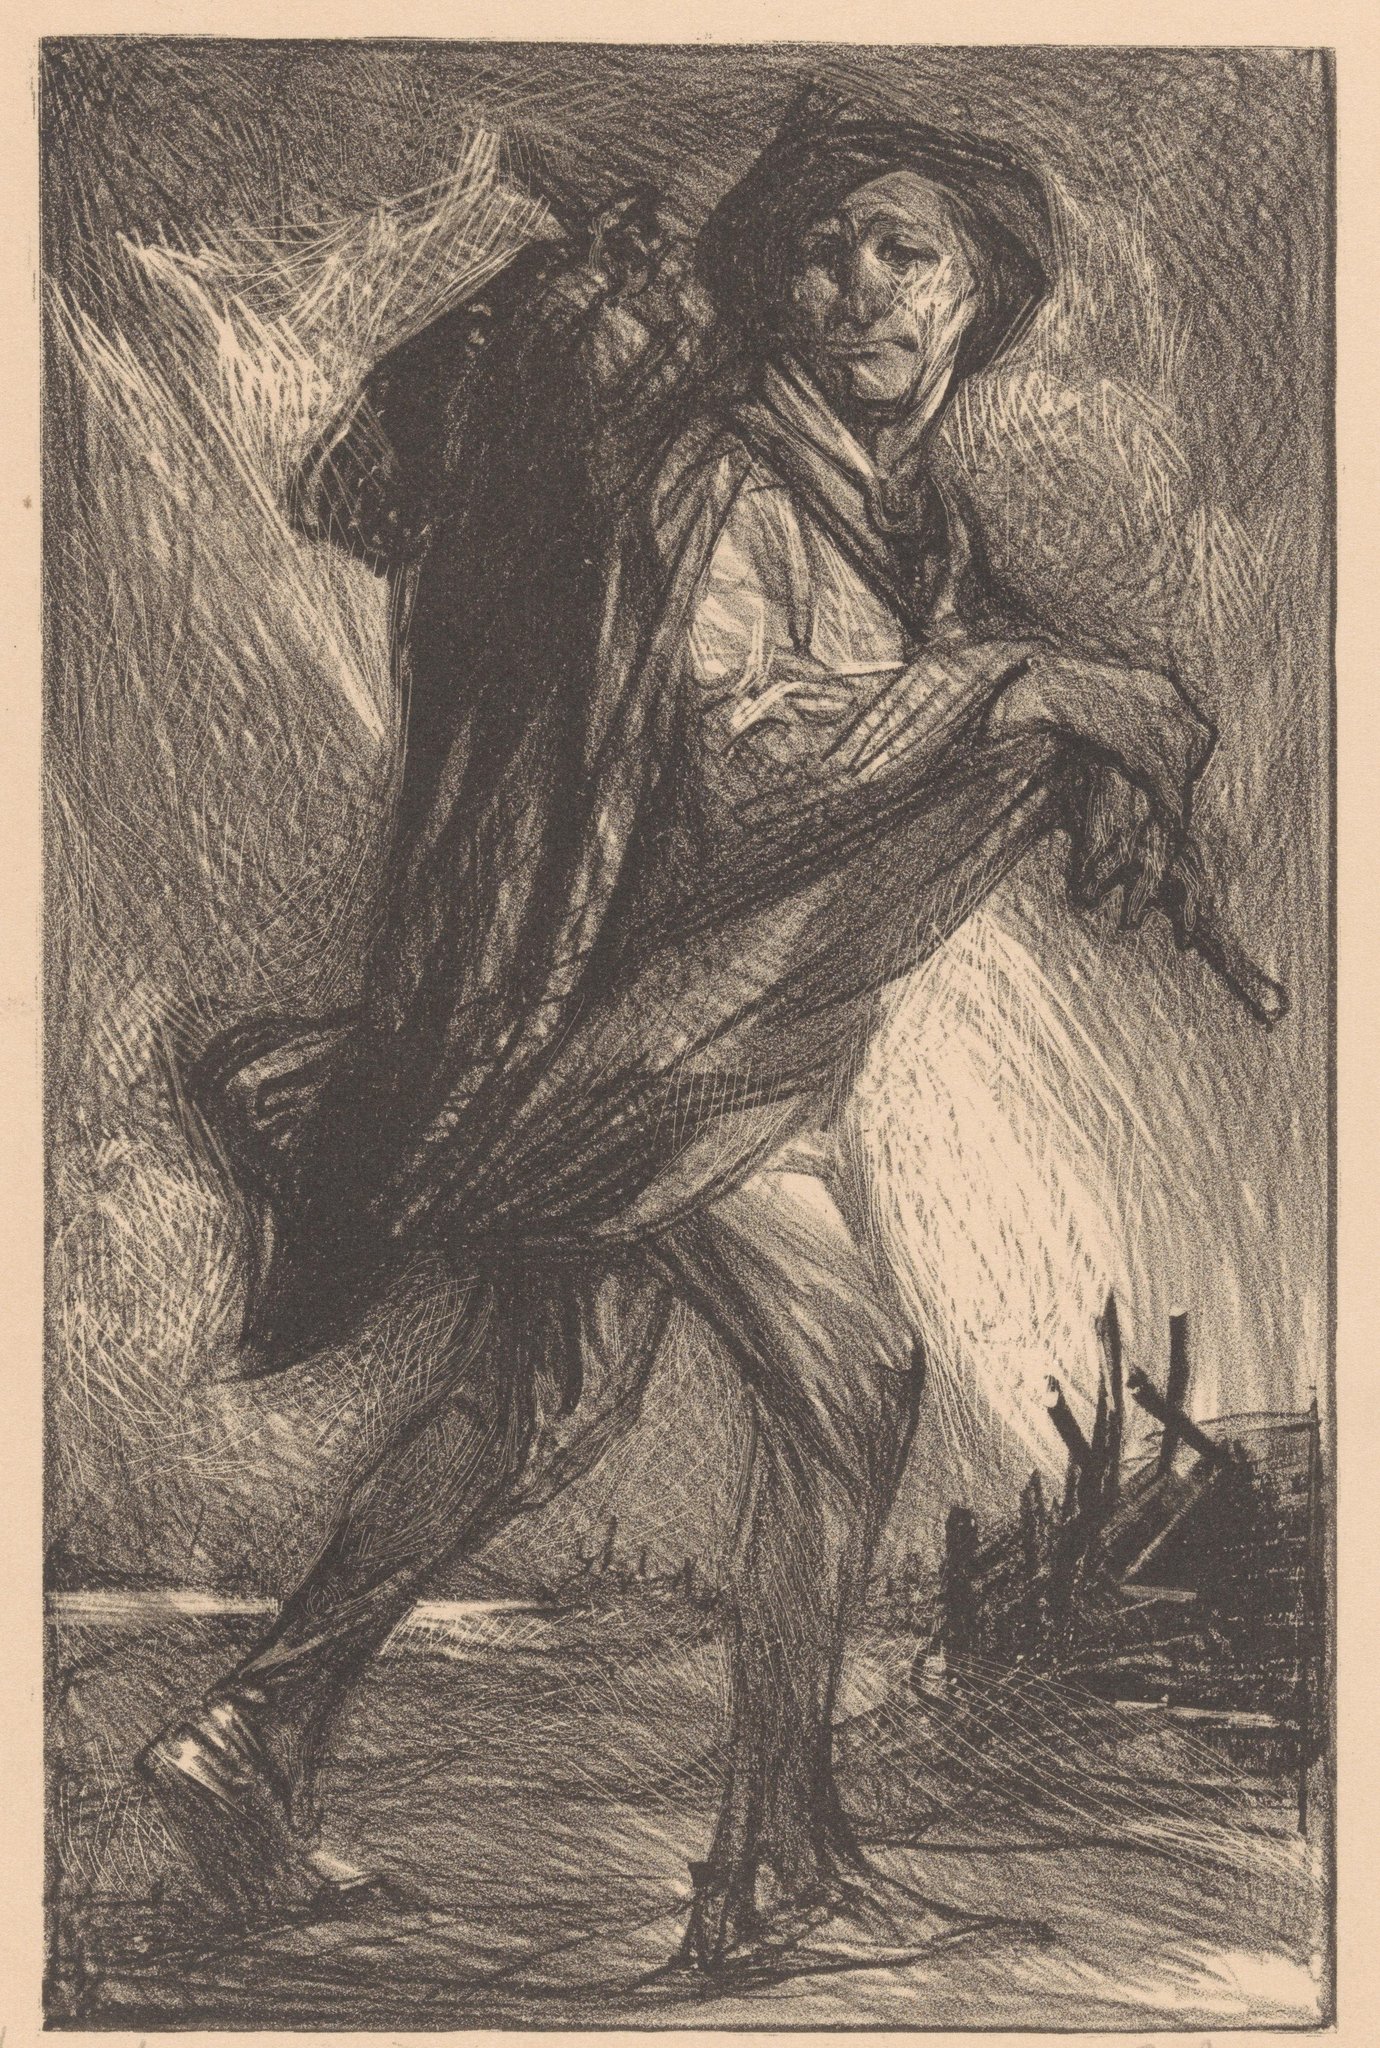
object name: print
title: Man met knapzak, mogelijk Tijl Uilenspiegel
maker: johannes josephus aarts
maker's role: draughtsman, print maker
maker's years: 1871-1934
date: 1927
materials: paper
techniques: lithograph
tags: 'fahrende leute', vagrants, eulenspiegel, knapsack, rucksack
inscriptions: collector's mark: Lugt 2228